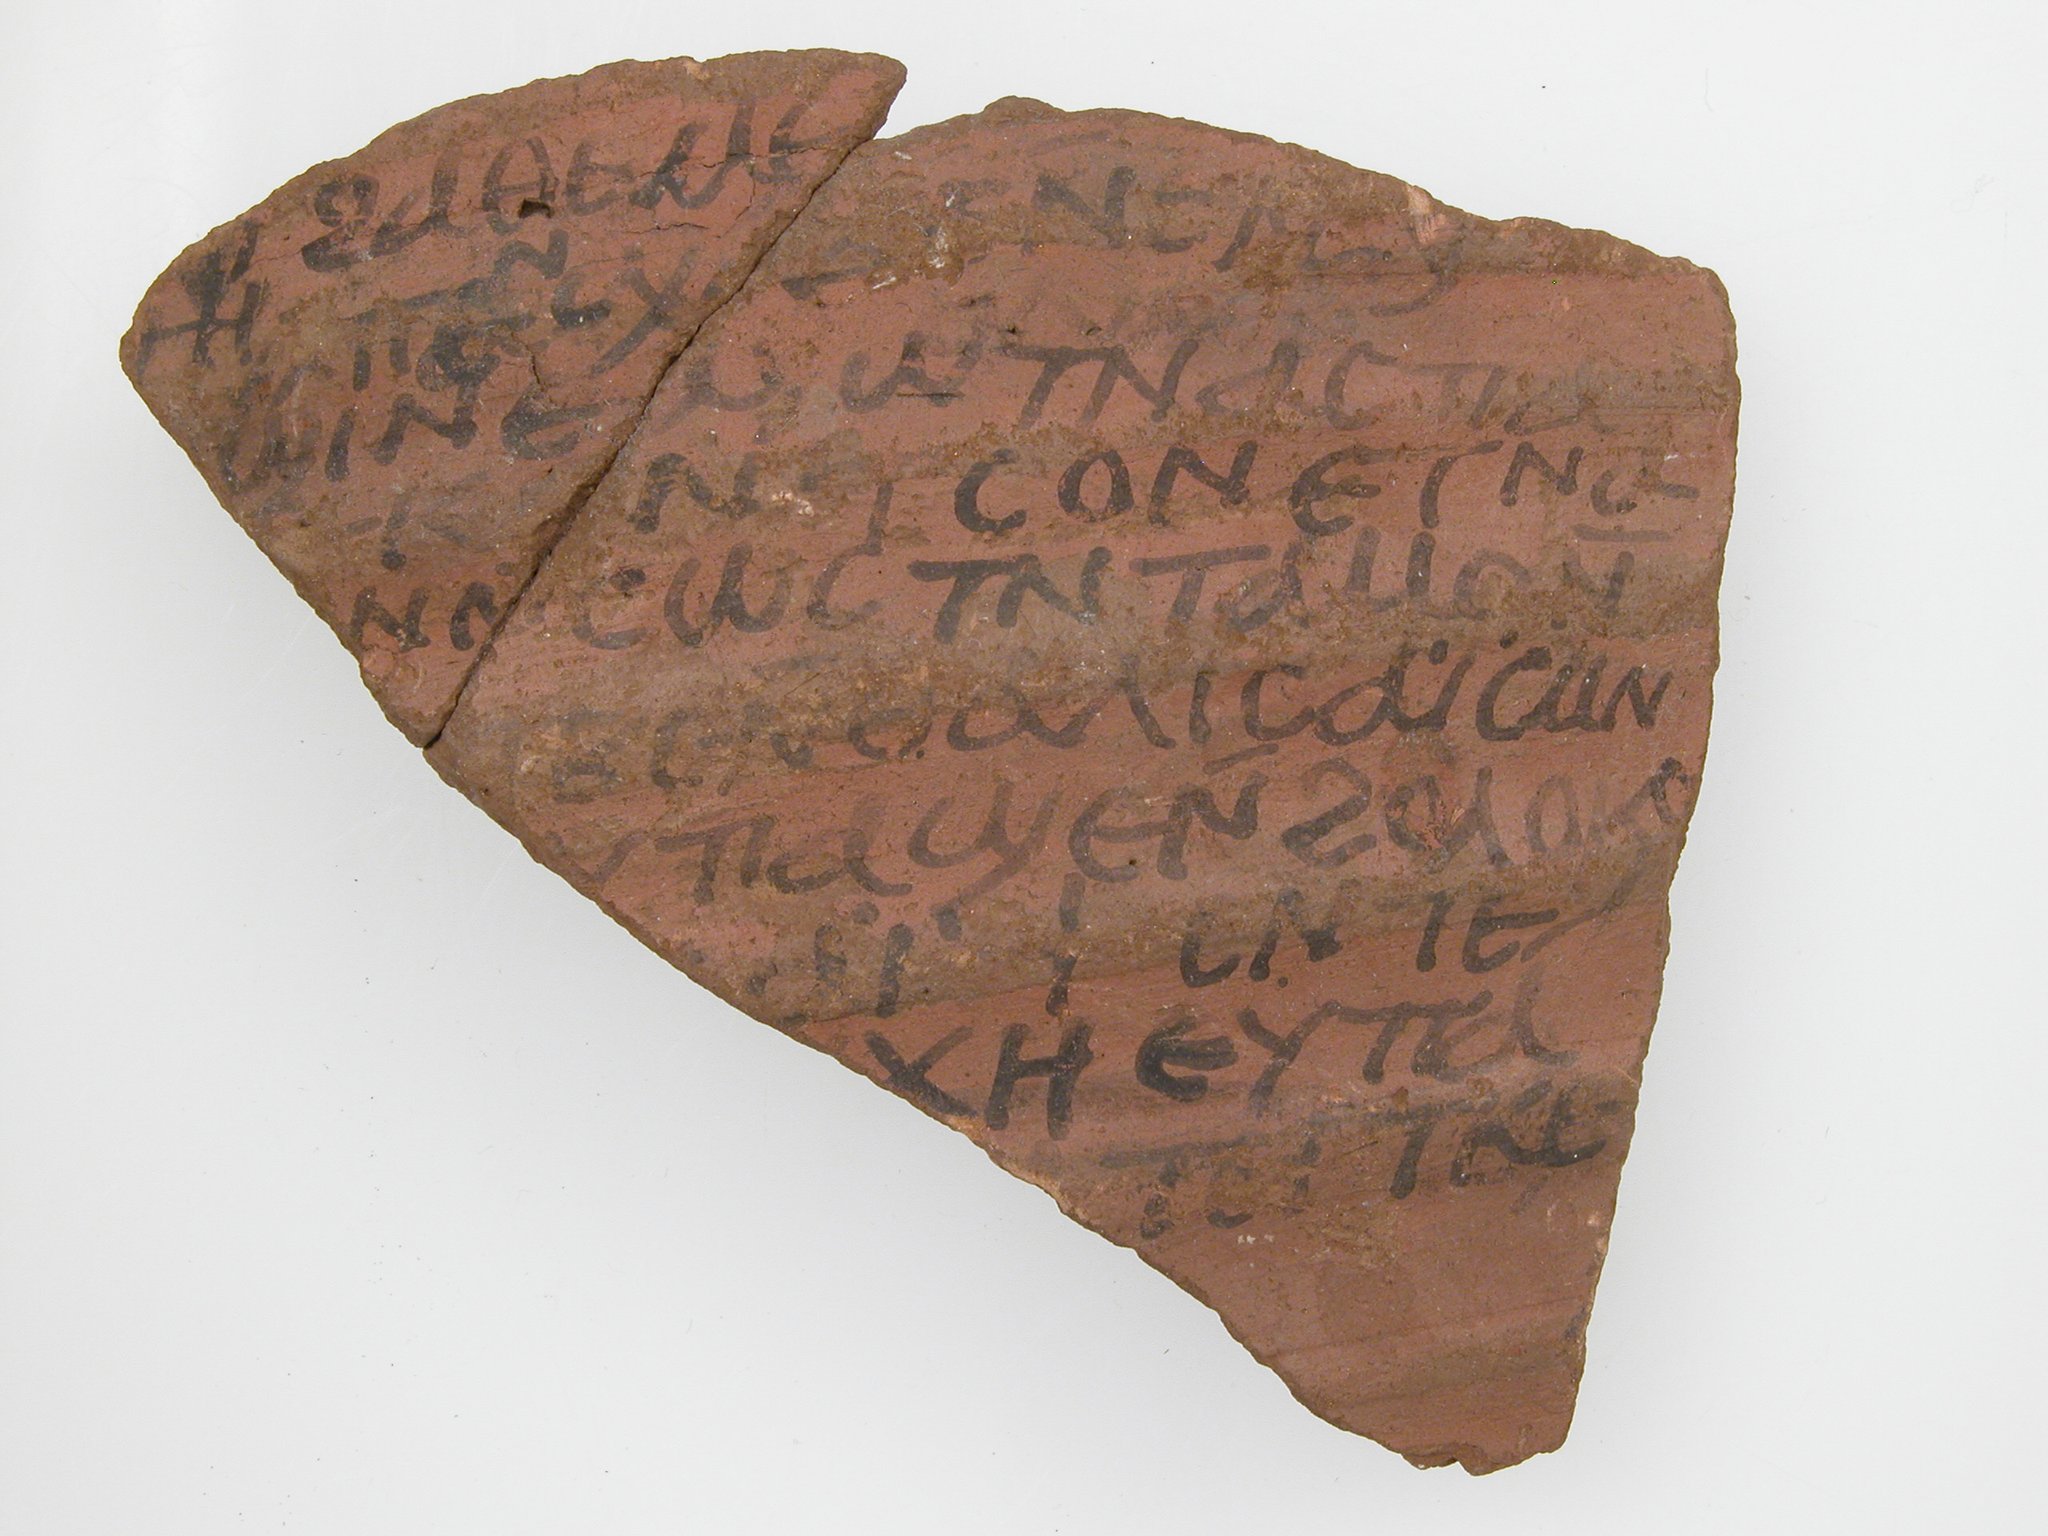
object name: ostrakon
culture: coptic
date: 601-700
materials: ink, pottery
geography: egypt